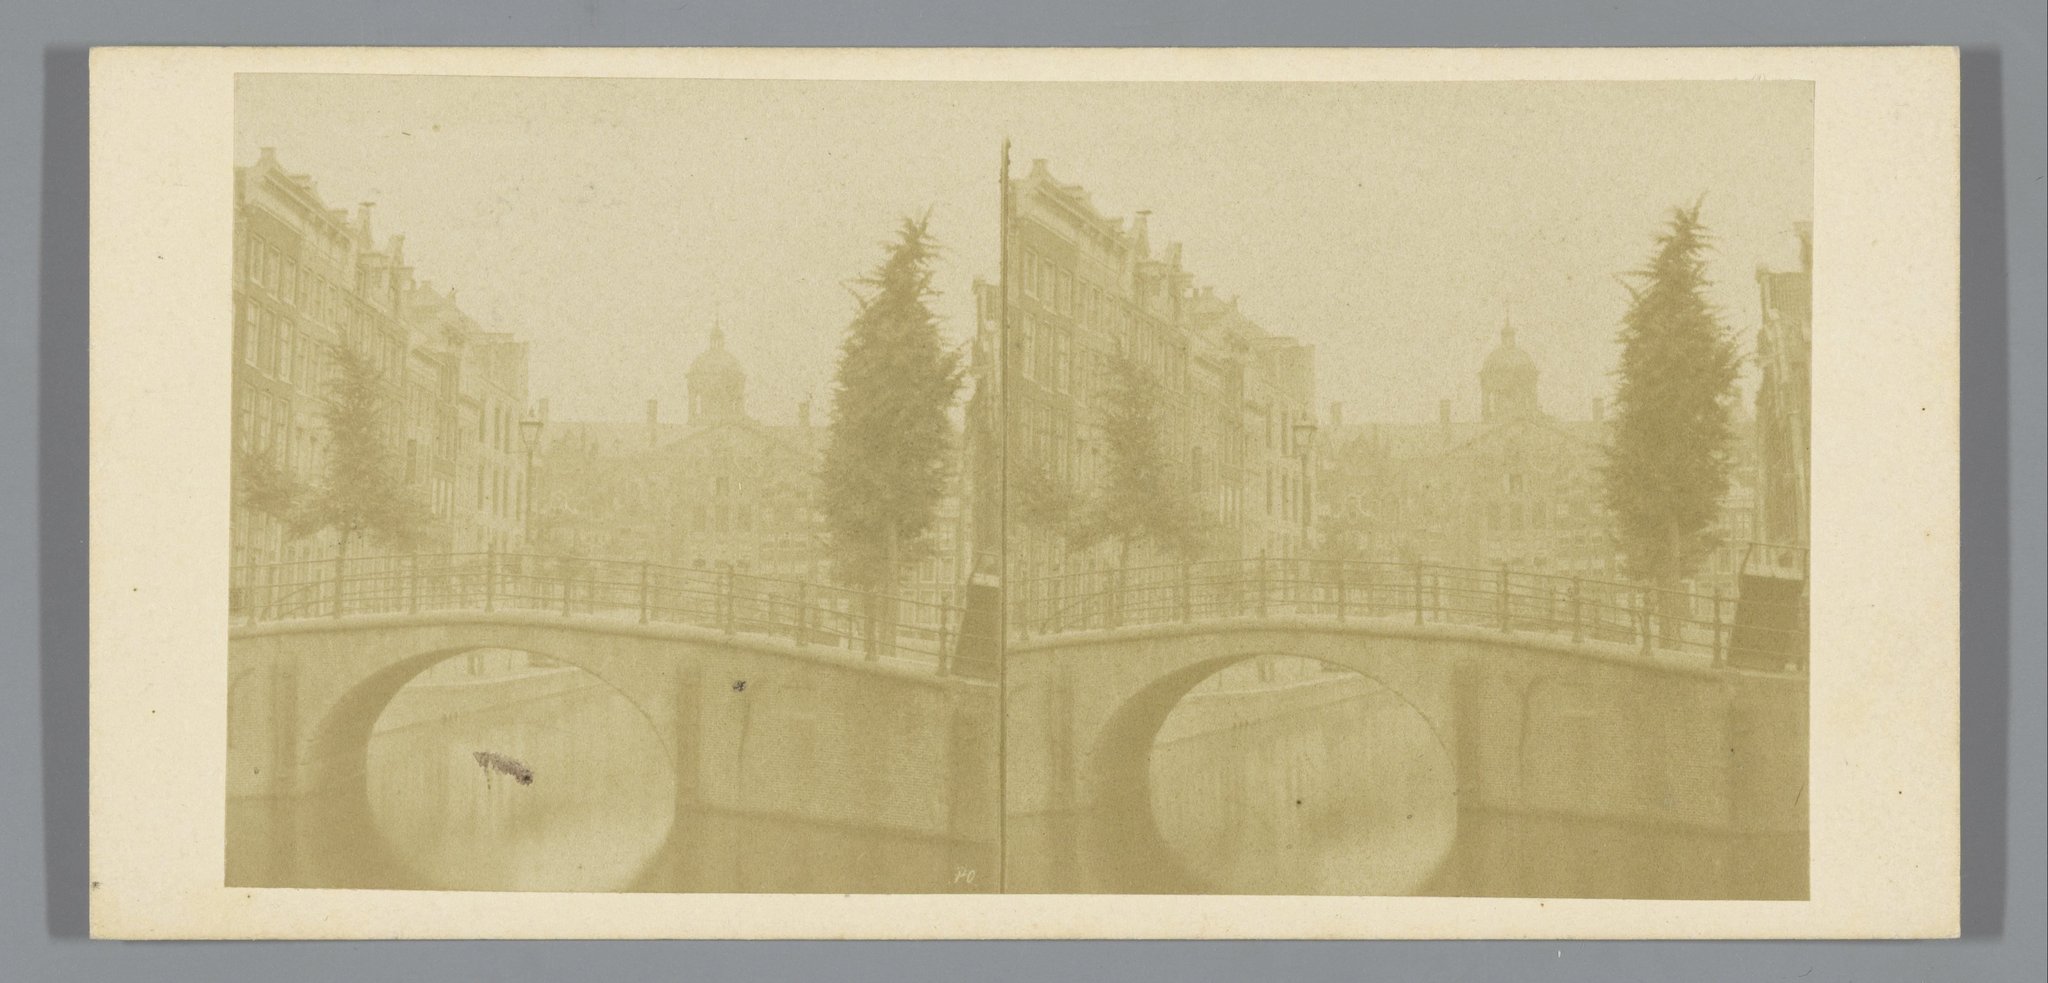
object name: stereograph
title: Vues de Hollande, Amsterdam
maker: pieter oosterhuis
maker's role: draughtsman, print maker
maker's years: 1816-1885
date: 1855-1870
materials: cardboard, paper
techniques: albumen print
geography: amsterdam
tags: bridge in city across river, canal, etc.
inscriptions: number: ‘257.’, initials: ‘P.O.’, inscription: ‘gesigneerd P(ieter) O(osterhuis)’